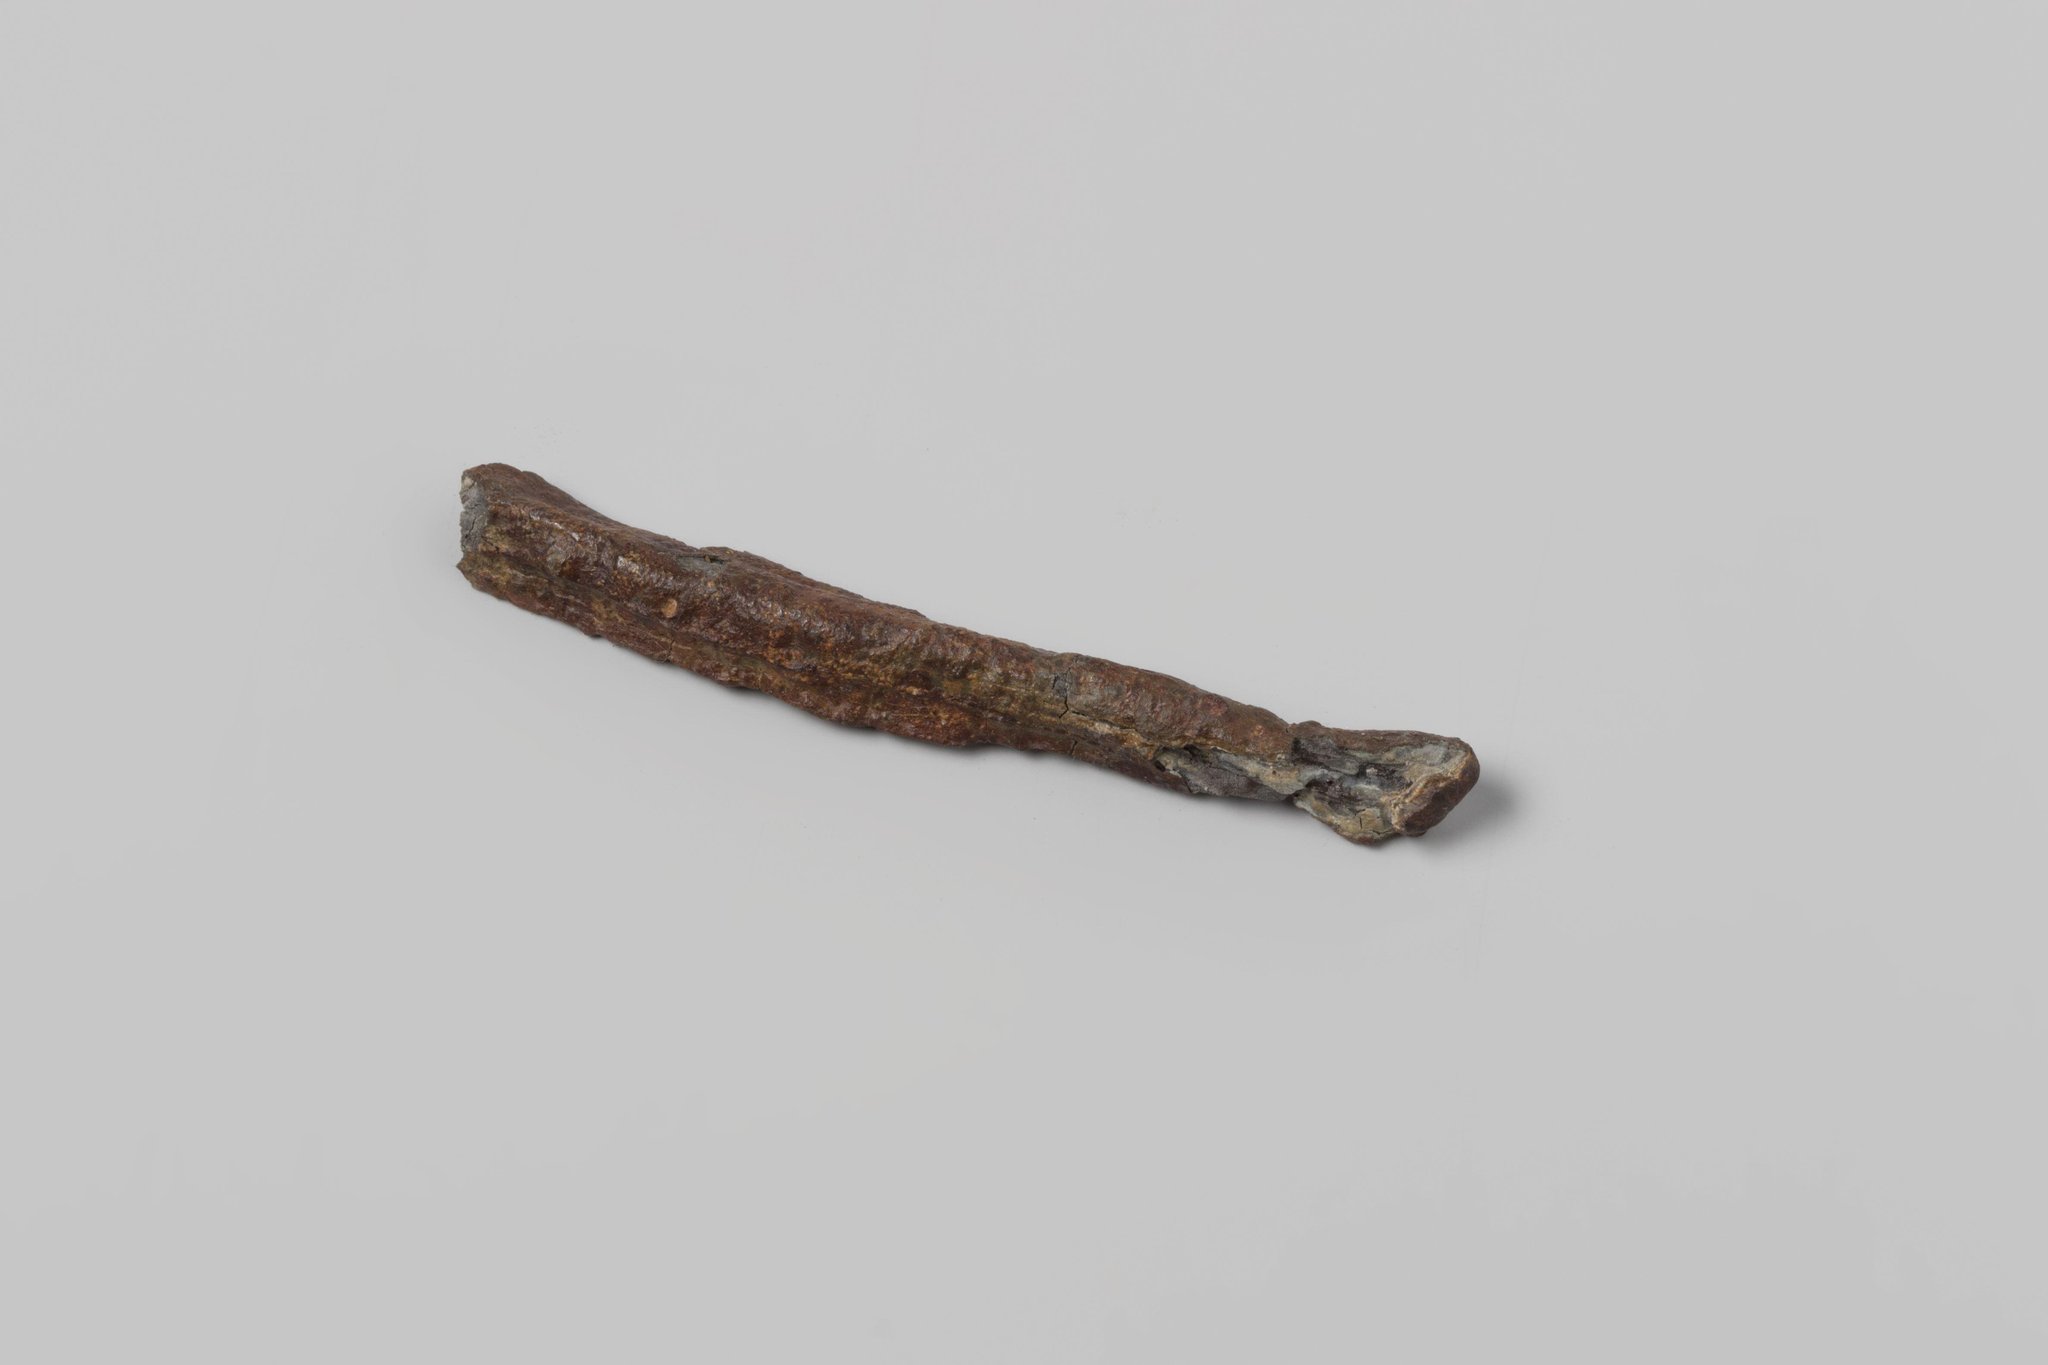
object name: fragment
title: Fragment tin uit het wrak van de Oost-Indiëvaarder Hollandia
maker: Anonymous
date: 1700-1743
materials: tin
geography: netherlands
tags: verenigde oostindische compagnie, hollandia (schip), annet